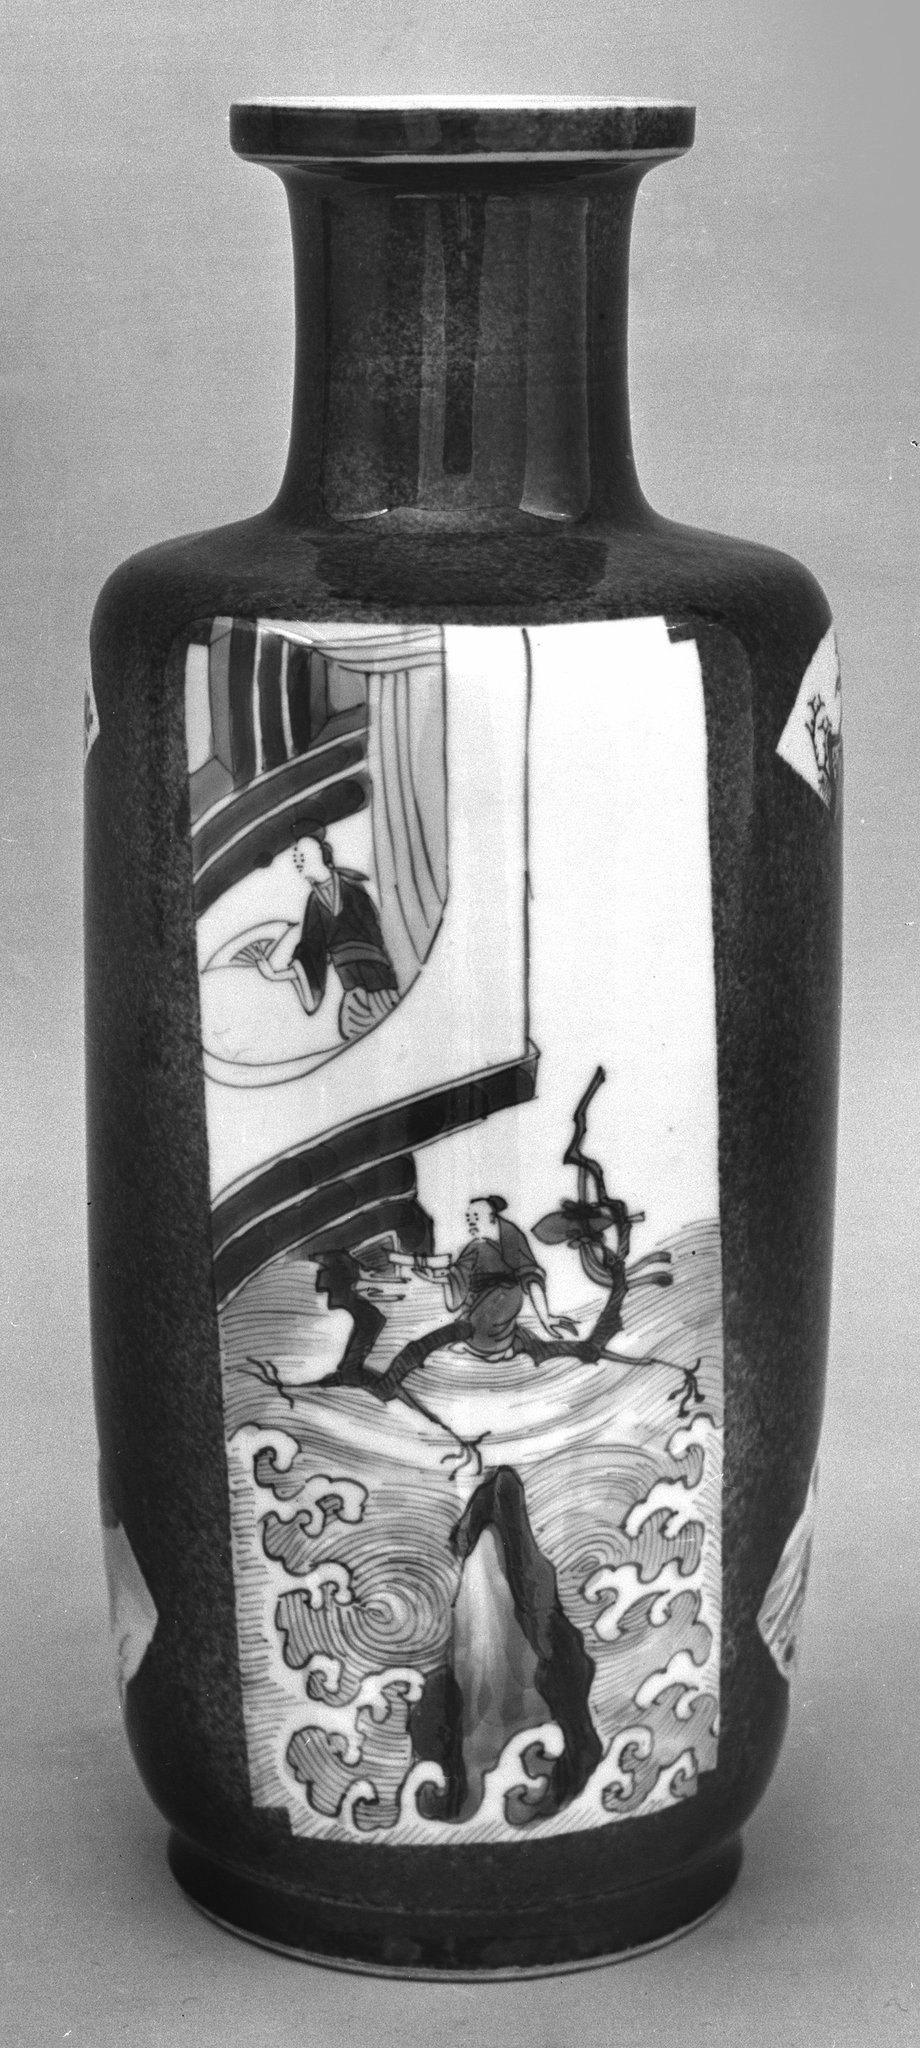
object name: vase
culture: chinese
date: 1667-1733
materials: glaze, porcelain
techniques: painting, underglaze